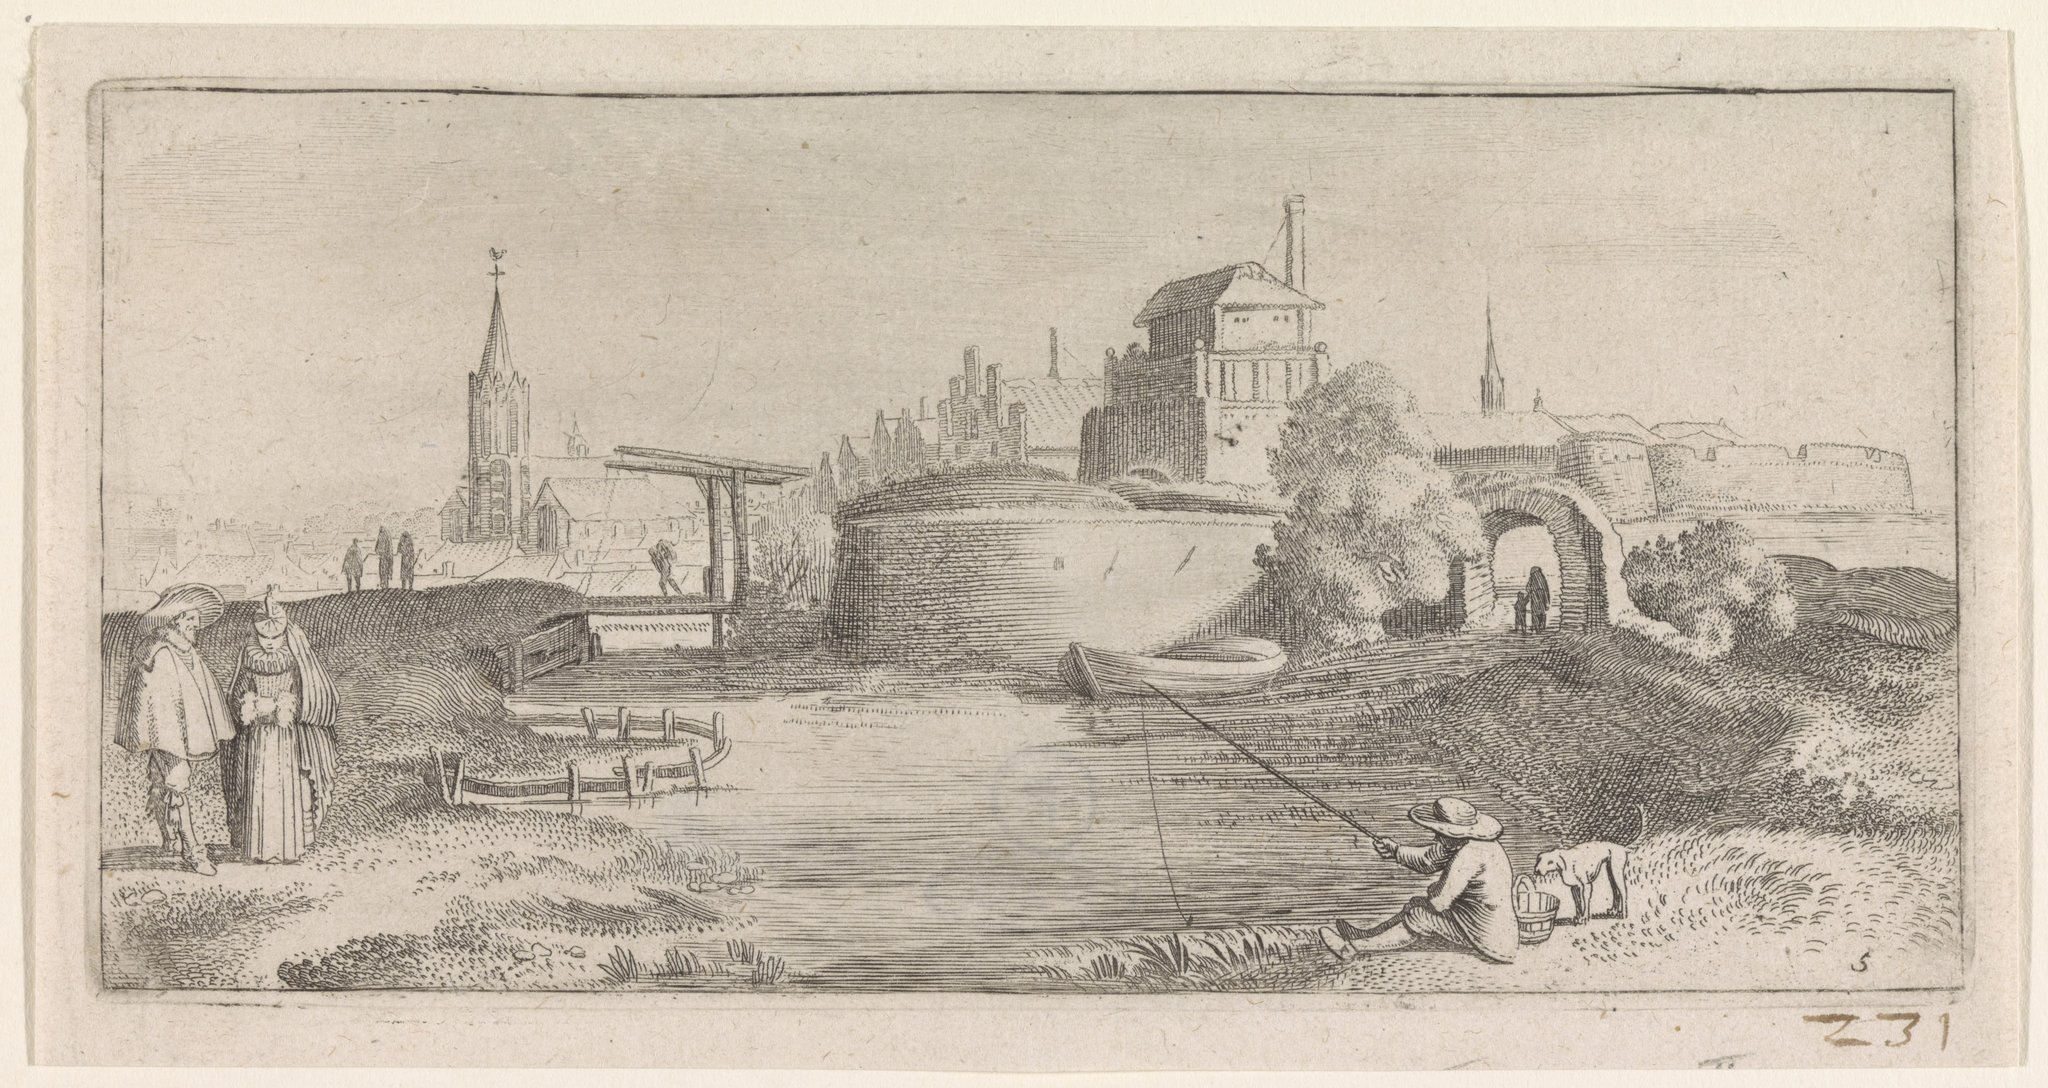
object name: print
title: Figuren in landschappen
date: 1627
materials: paper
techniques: engraving, etching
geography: northern netherlands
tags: bascule bridge, landscape with bridge, viaduct or aqueduct, gate, entrance, walls ~ fortified city, fortified city, angling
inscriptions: collector's mark: Lugt 964, number: ‘231’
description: Een hengelaar met een hond aan een waterkant bij een versterkte stad met een poort en een ophaalbrug. Linksvoor een converserend paar. Op de achtergrond een kerk. Rechtsonder genummerd: 5. De genummerde prenten zijn als serie van tien uitgeven.